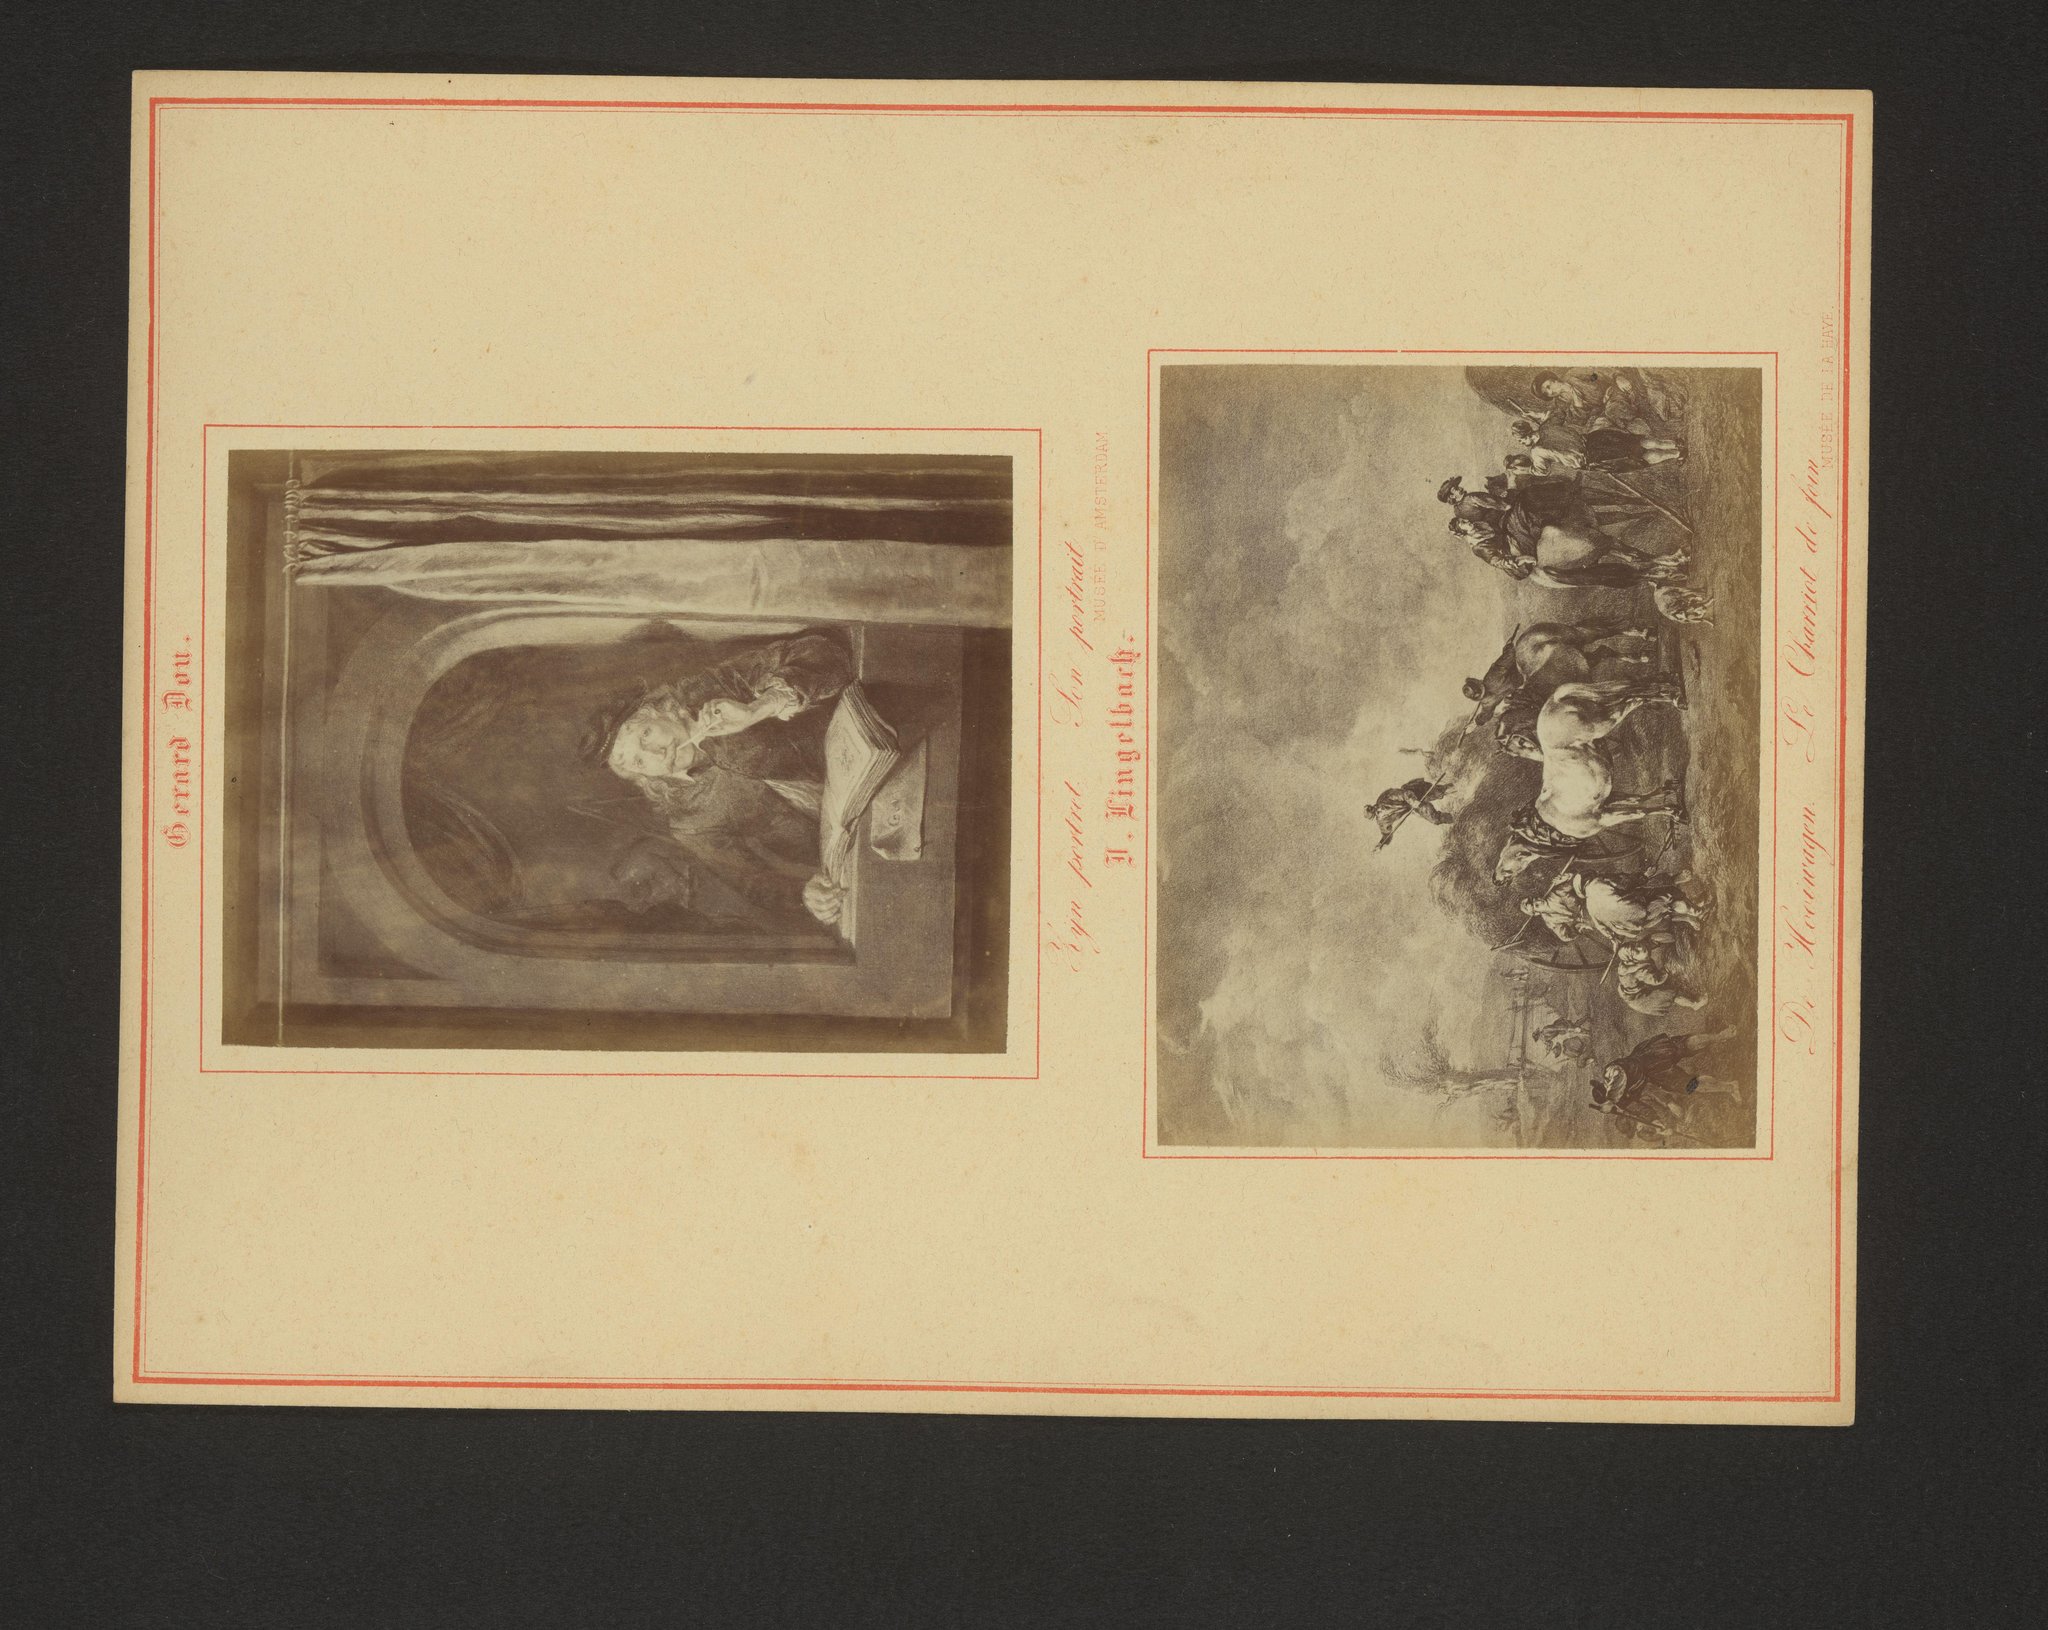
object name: photograph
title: J. Lingelbach - De Hooiwagen, Le Charriot de foin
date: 1866-1874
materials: cardboard, photographic support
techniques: albumen print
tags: harvest, historical persons, pipe ~ tobacco, book - mm - book open, transporting ~ harvest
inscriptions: annotation: ‘Musée de La Haye’, annotation: ‘Musée d'Amsterdam’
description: Deze foto maakt deel uit van een omslag met 25 foto's.